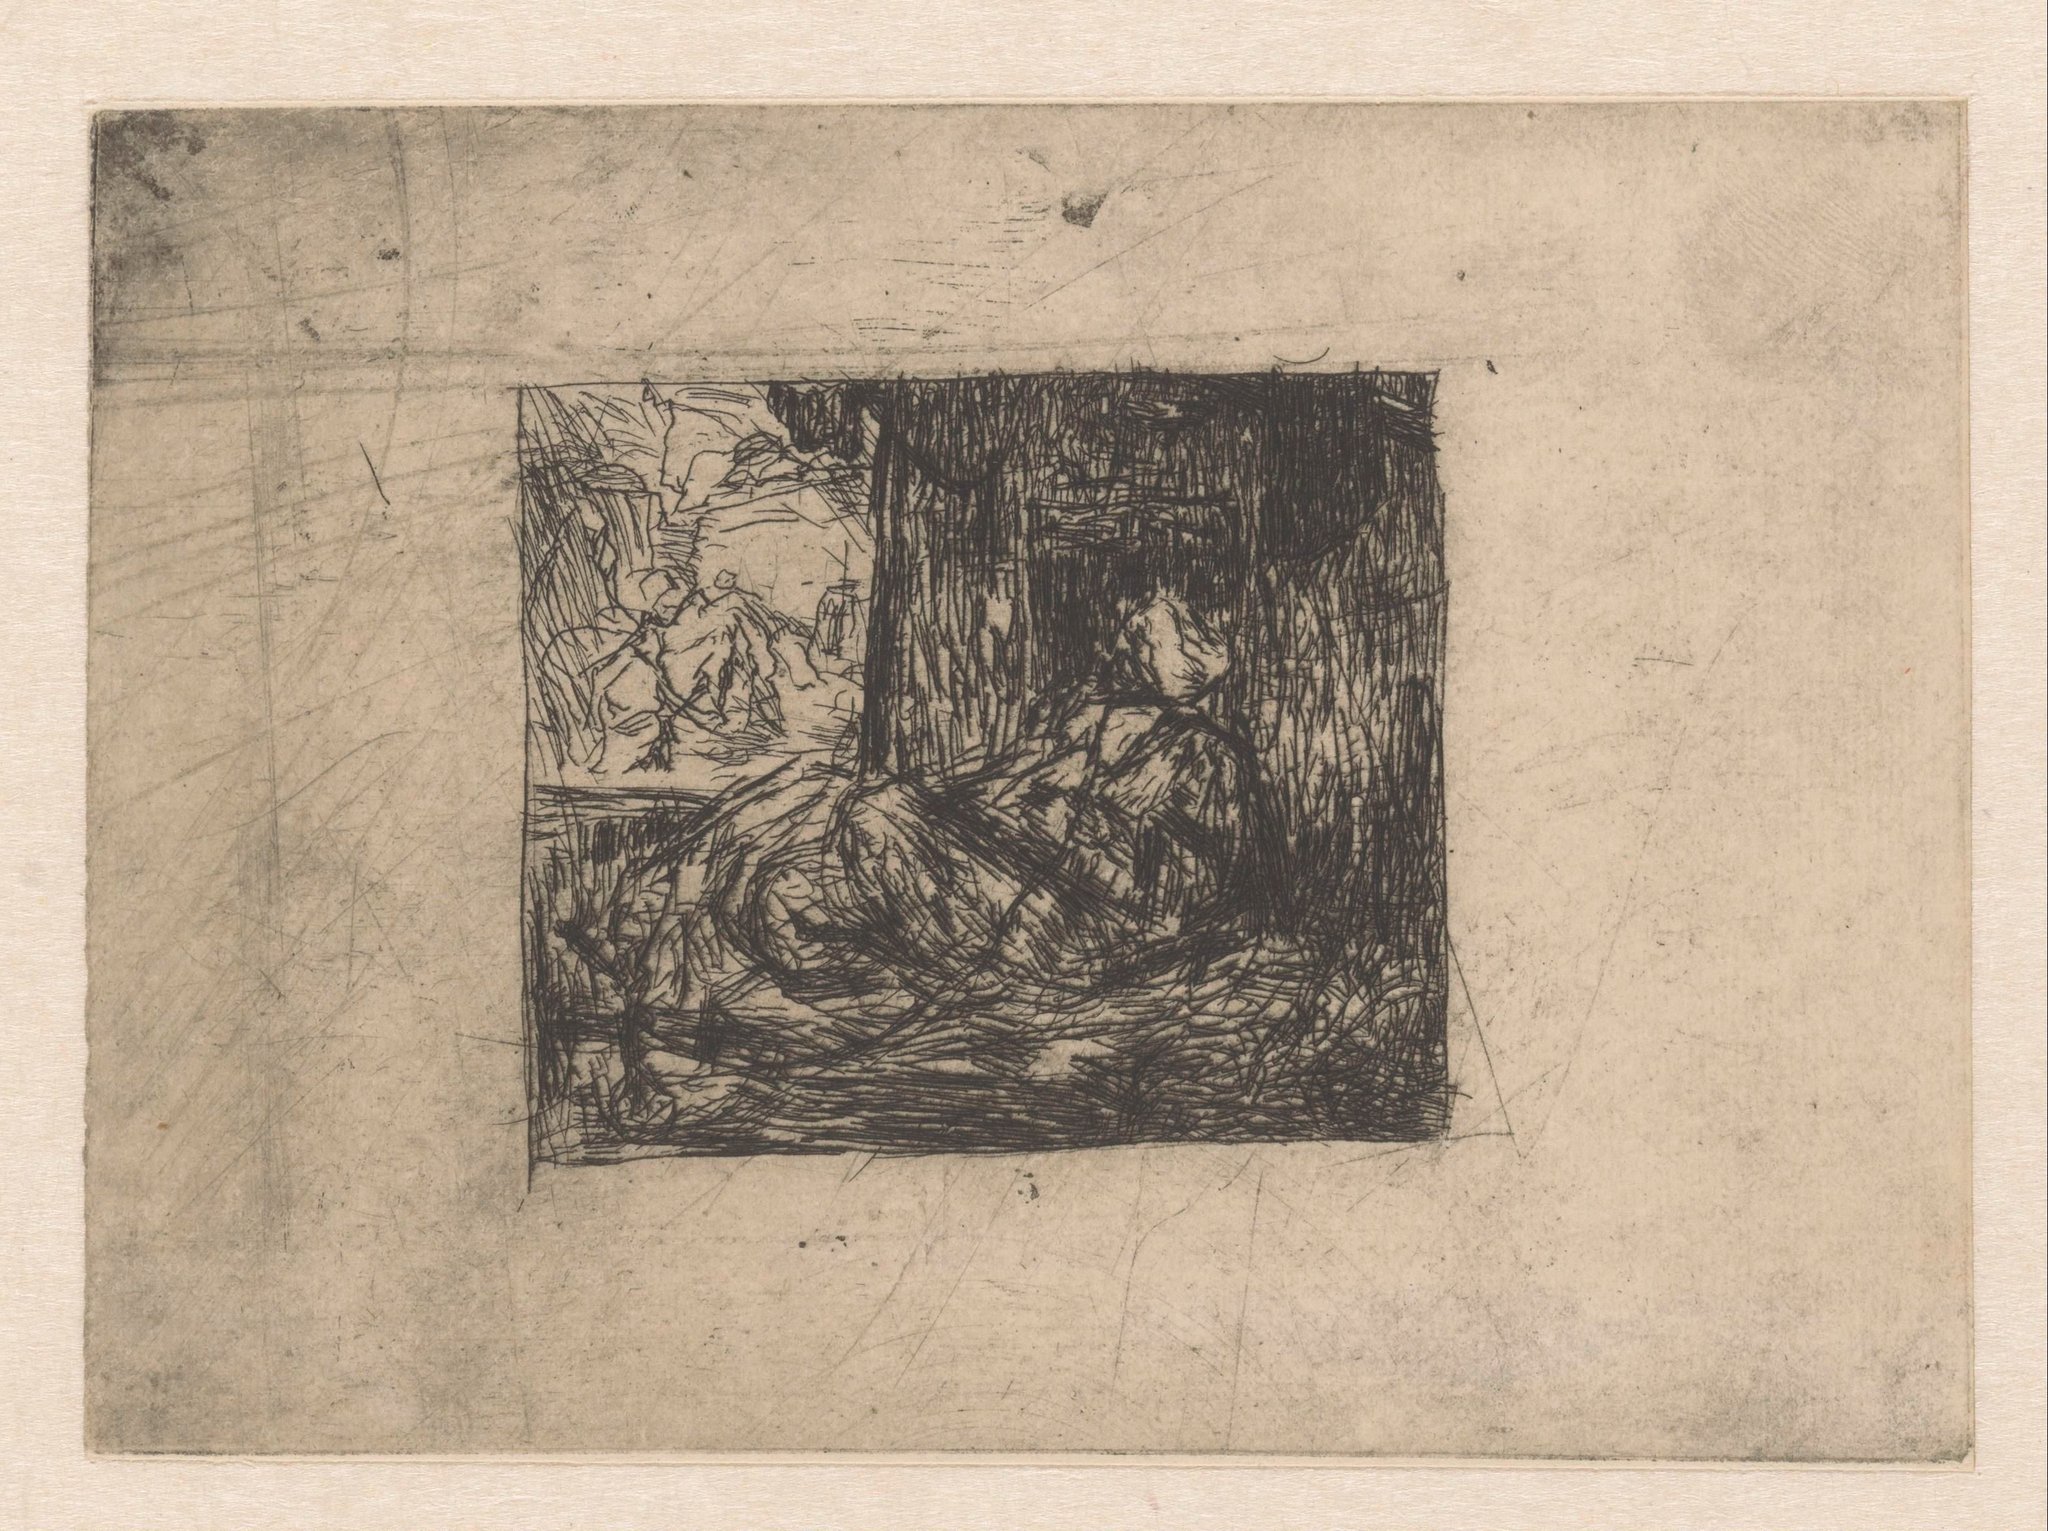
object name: print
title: Man met waterpijp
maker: marius bauer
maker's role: draughtsman, print maker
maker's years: 1867-1932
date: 1889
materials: paper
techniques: etching, intaglio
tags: adult man (+ lying), water-pipe, hookah, narghile (+ taking (particular) foodstuffs: eating, drinking, smoking, chewing, etc.)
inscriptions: collector's mark: Lugt 2228